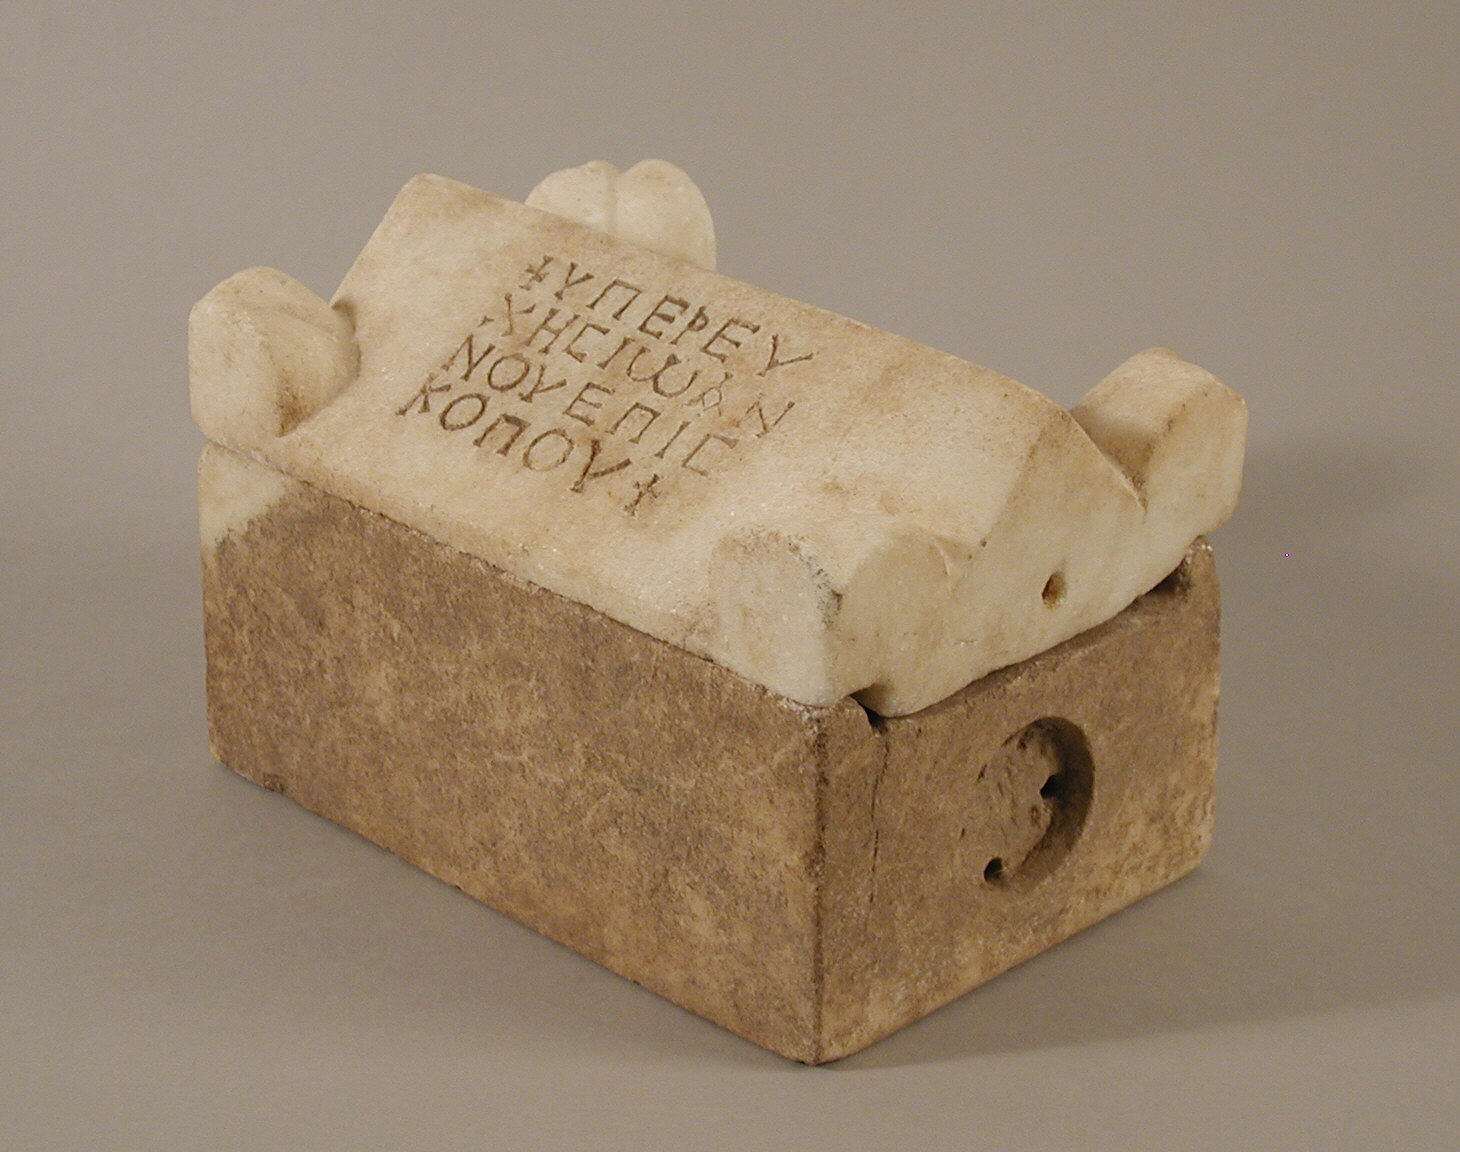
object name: reliquary casket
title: Reliquary in the Shape of a Sarcophagus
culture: byzantine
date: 400-600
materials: marble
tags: sarcophagus